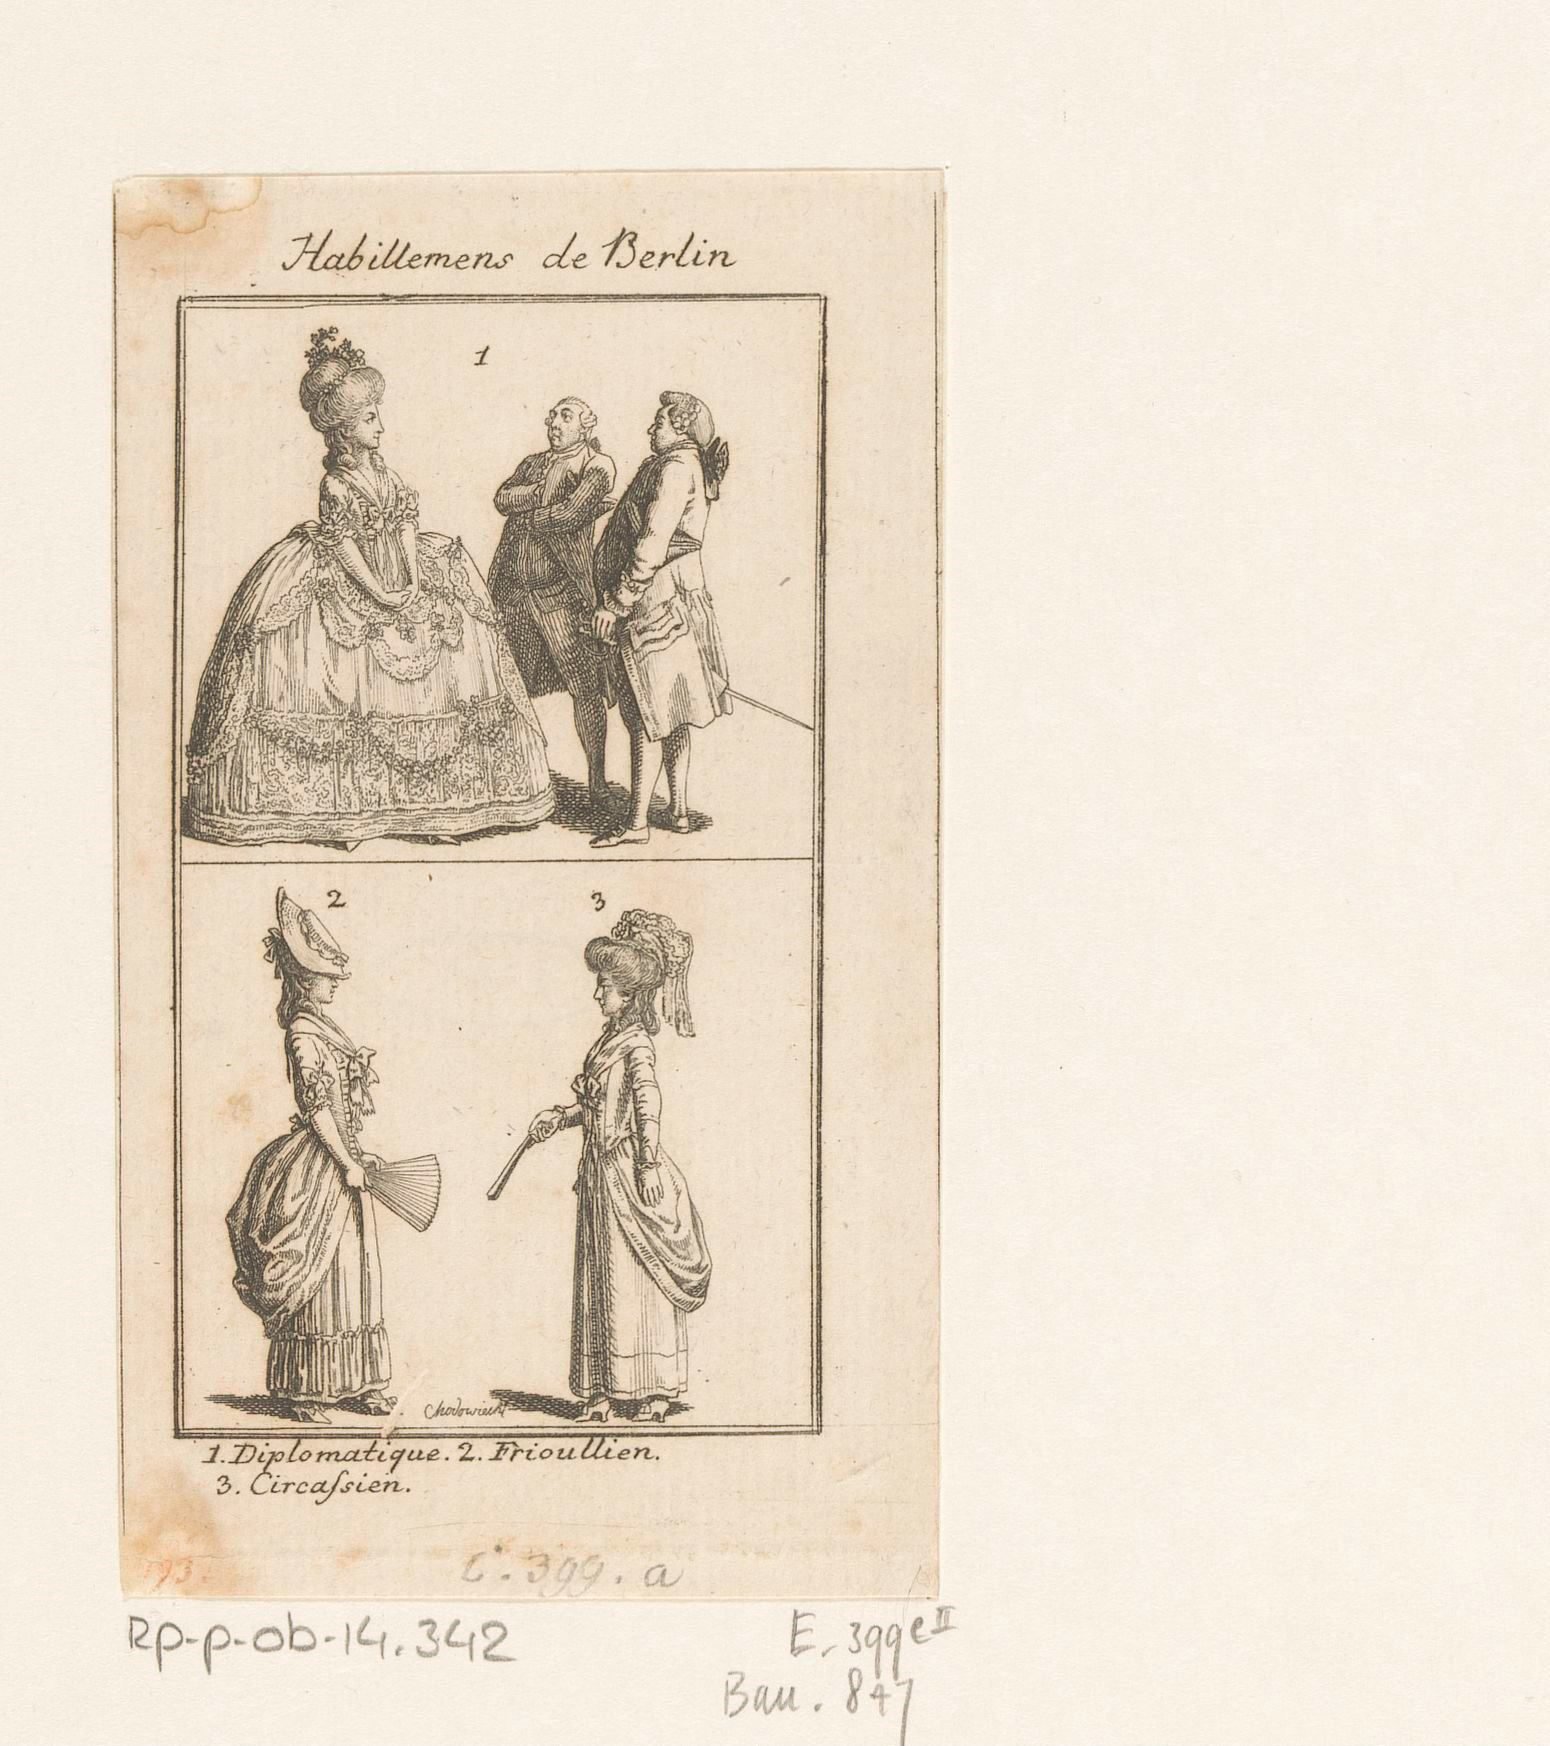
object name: print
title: Habillemens de Berlin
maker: daniel nikolaus chodowiecki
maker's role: draughtsman, print maker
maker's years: 1726-1801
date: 1781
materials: paper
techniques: etching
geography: berlin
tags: fashion, clothing, clothes for special purposes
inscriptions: collector's mark: Lugt 2228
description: Prent gebruikt voor: Königl. Gros. Britt. Genealogischer Kalender auf das 1782 Jahr. Lauenburger: J.G. Berenberg, 1782.